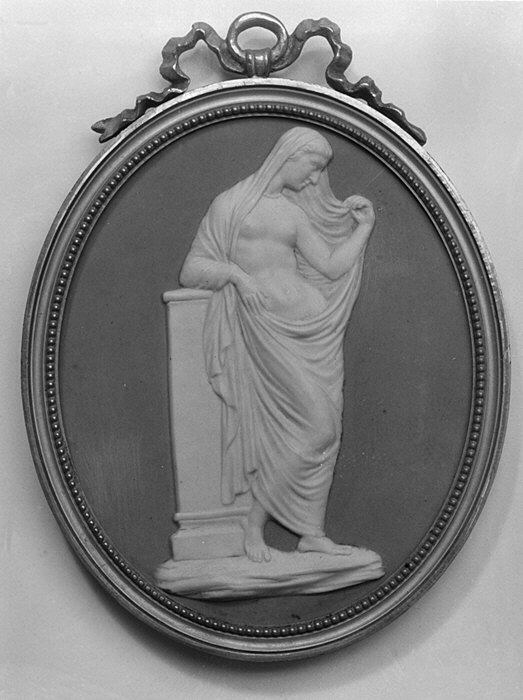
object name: cameo medallion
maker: wedgwood and bentley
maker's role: maker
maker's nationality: british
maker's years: 1769-1780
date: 1769-1780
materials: gilt bronze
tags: female nudes